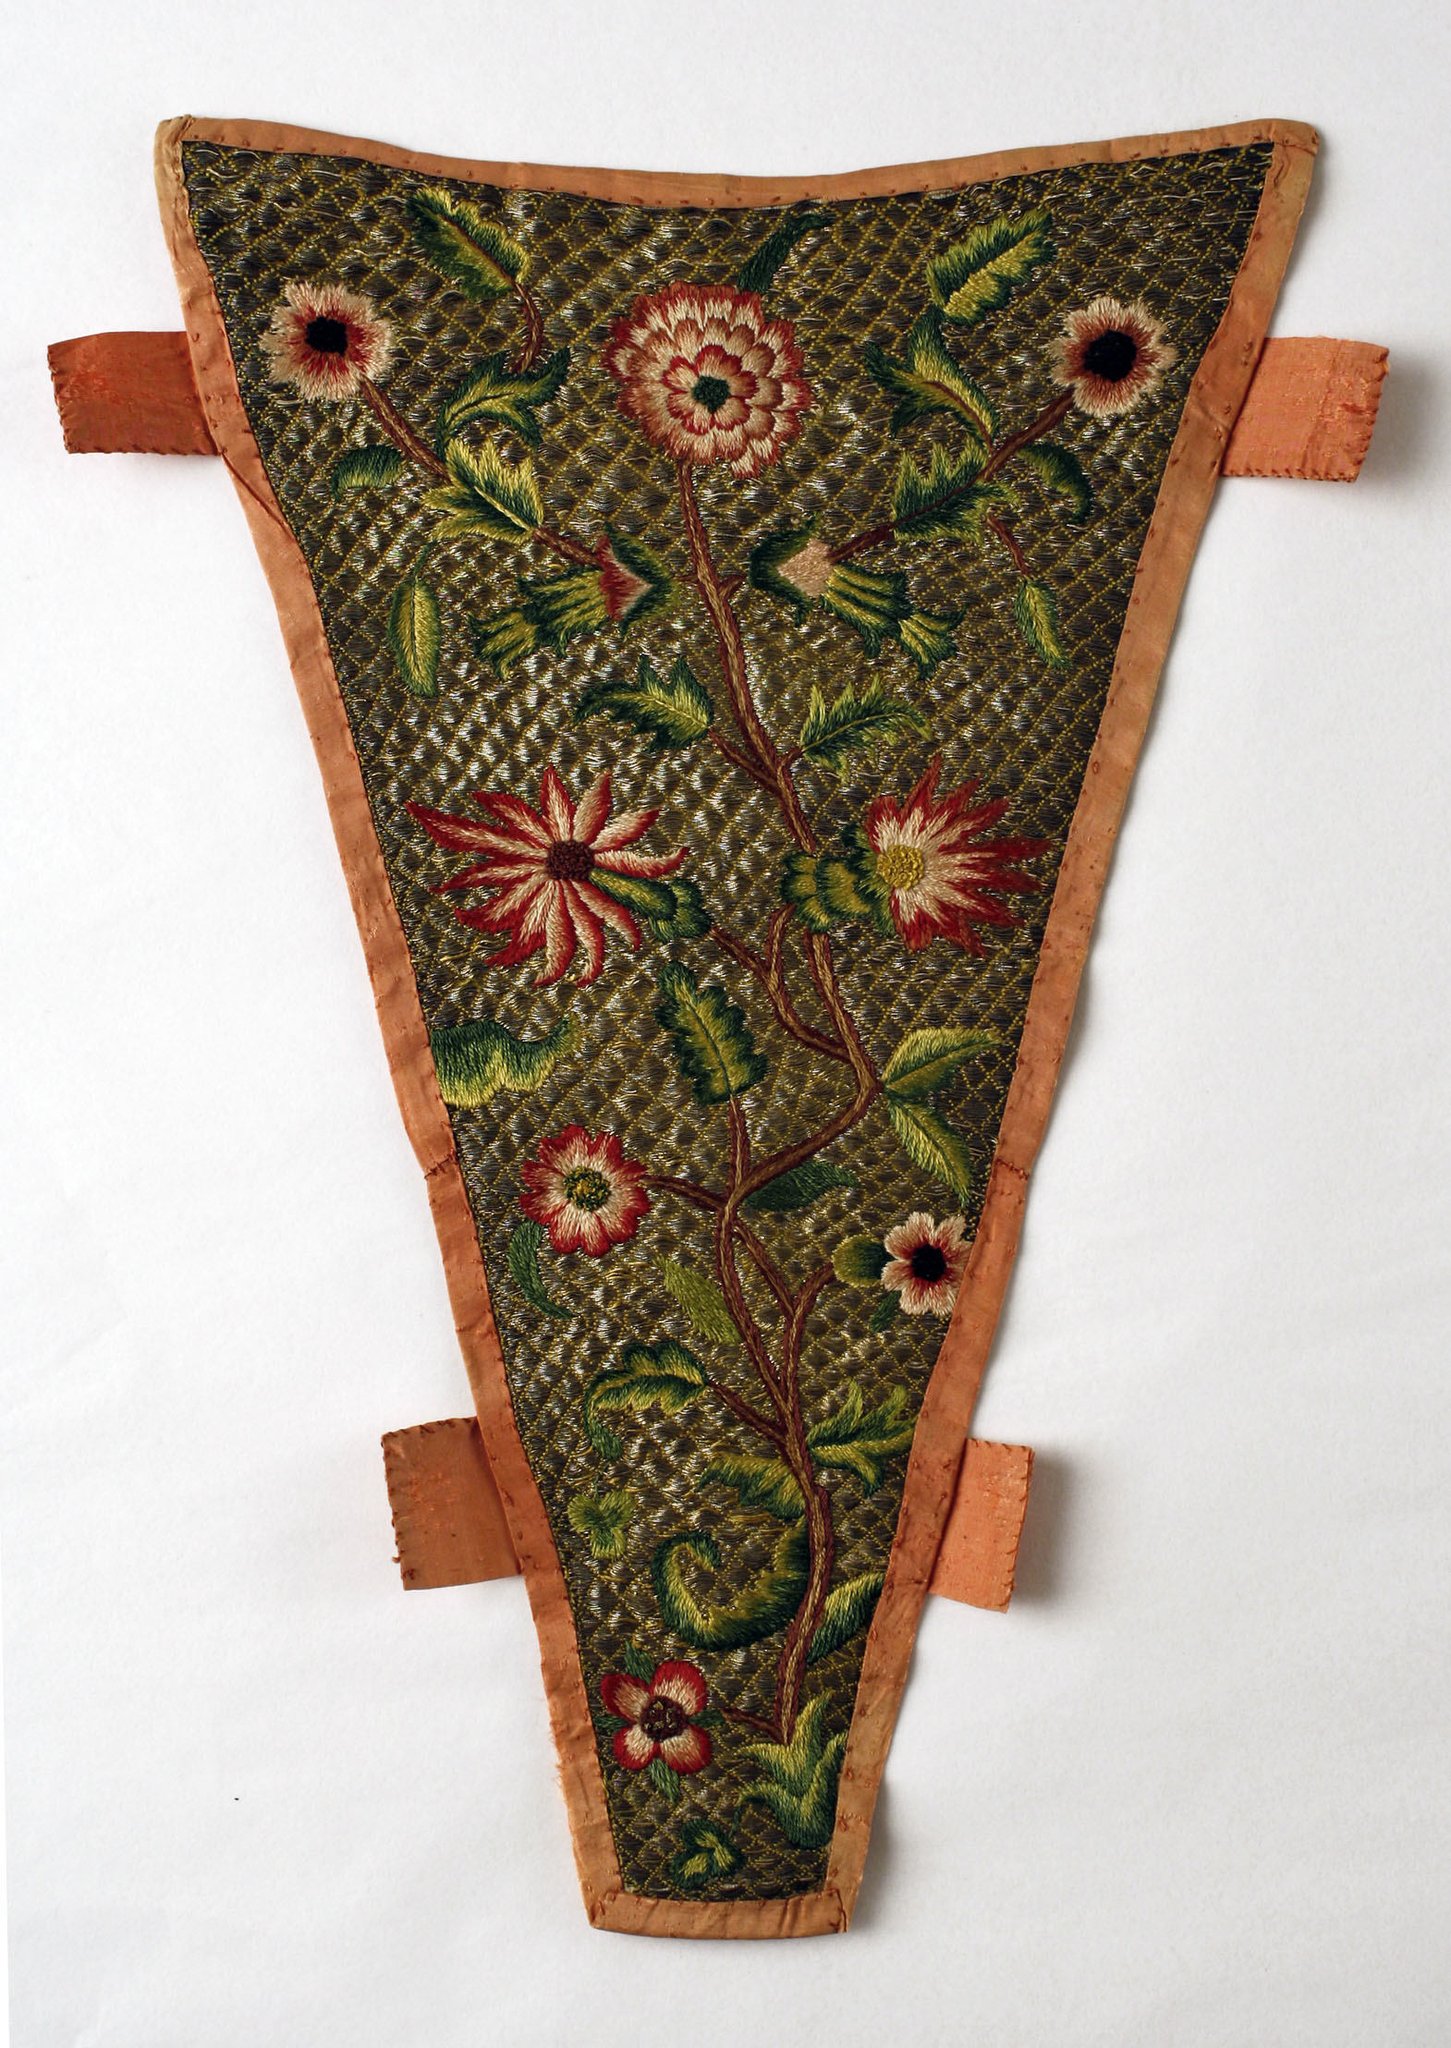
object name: stomacher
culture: british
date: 1720-1729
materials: metal, silk